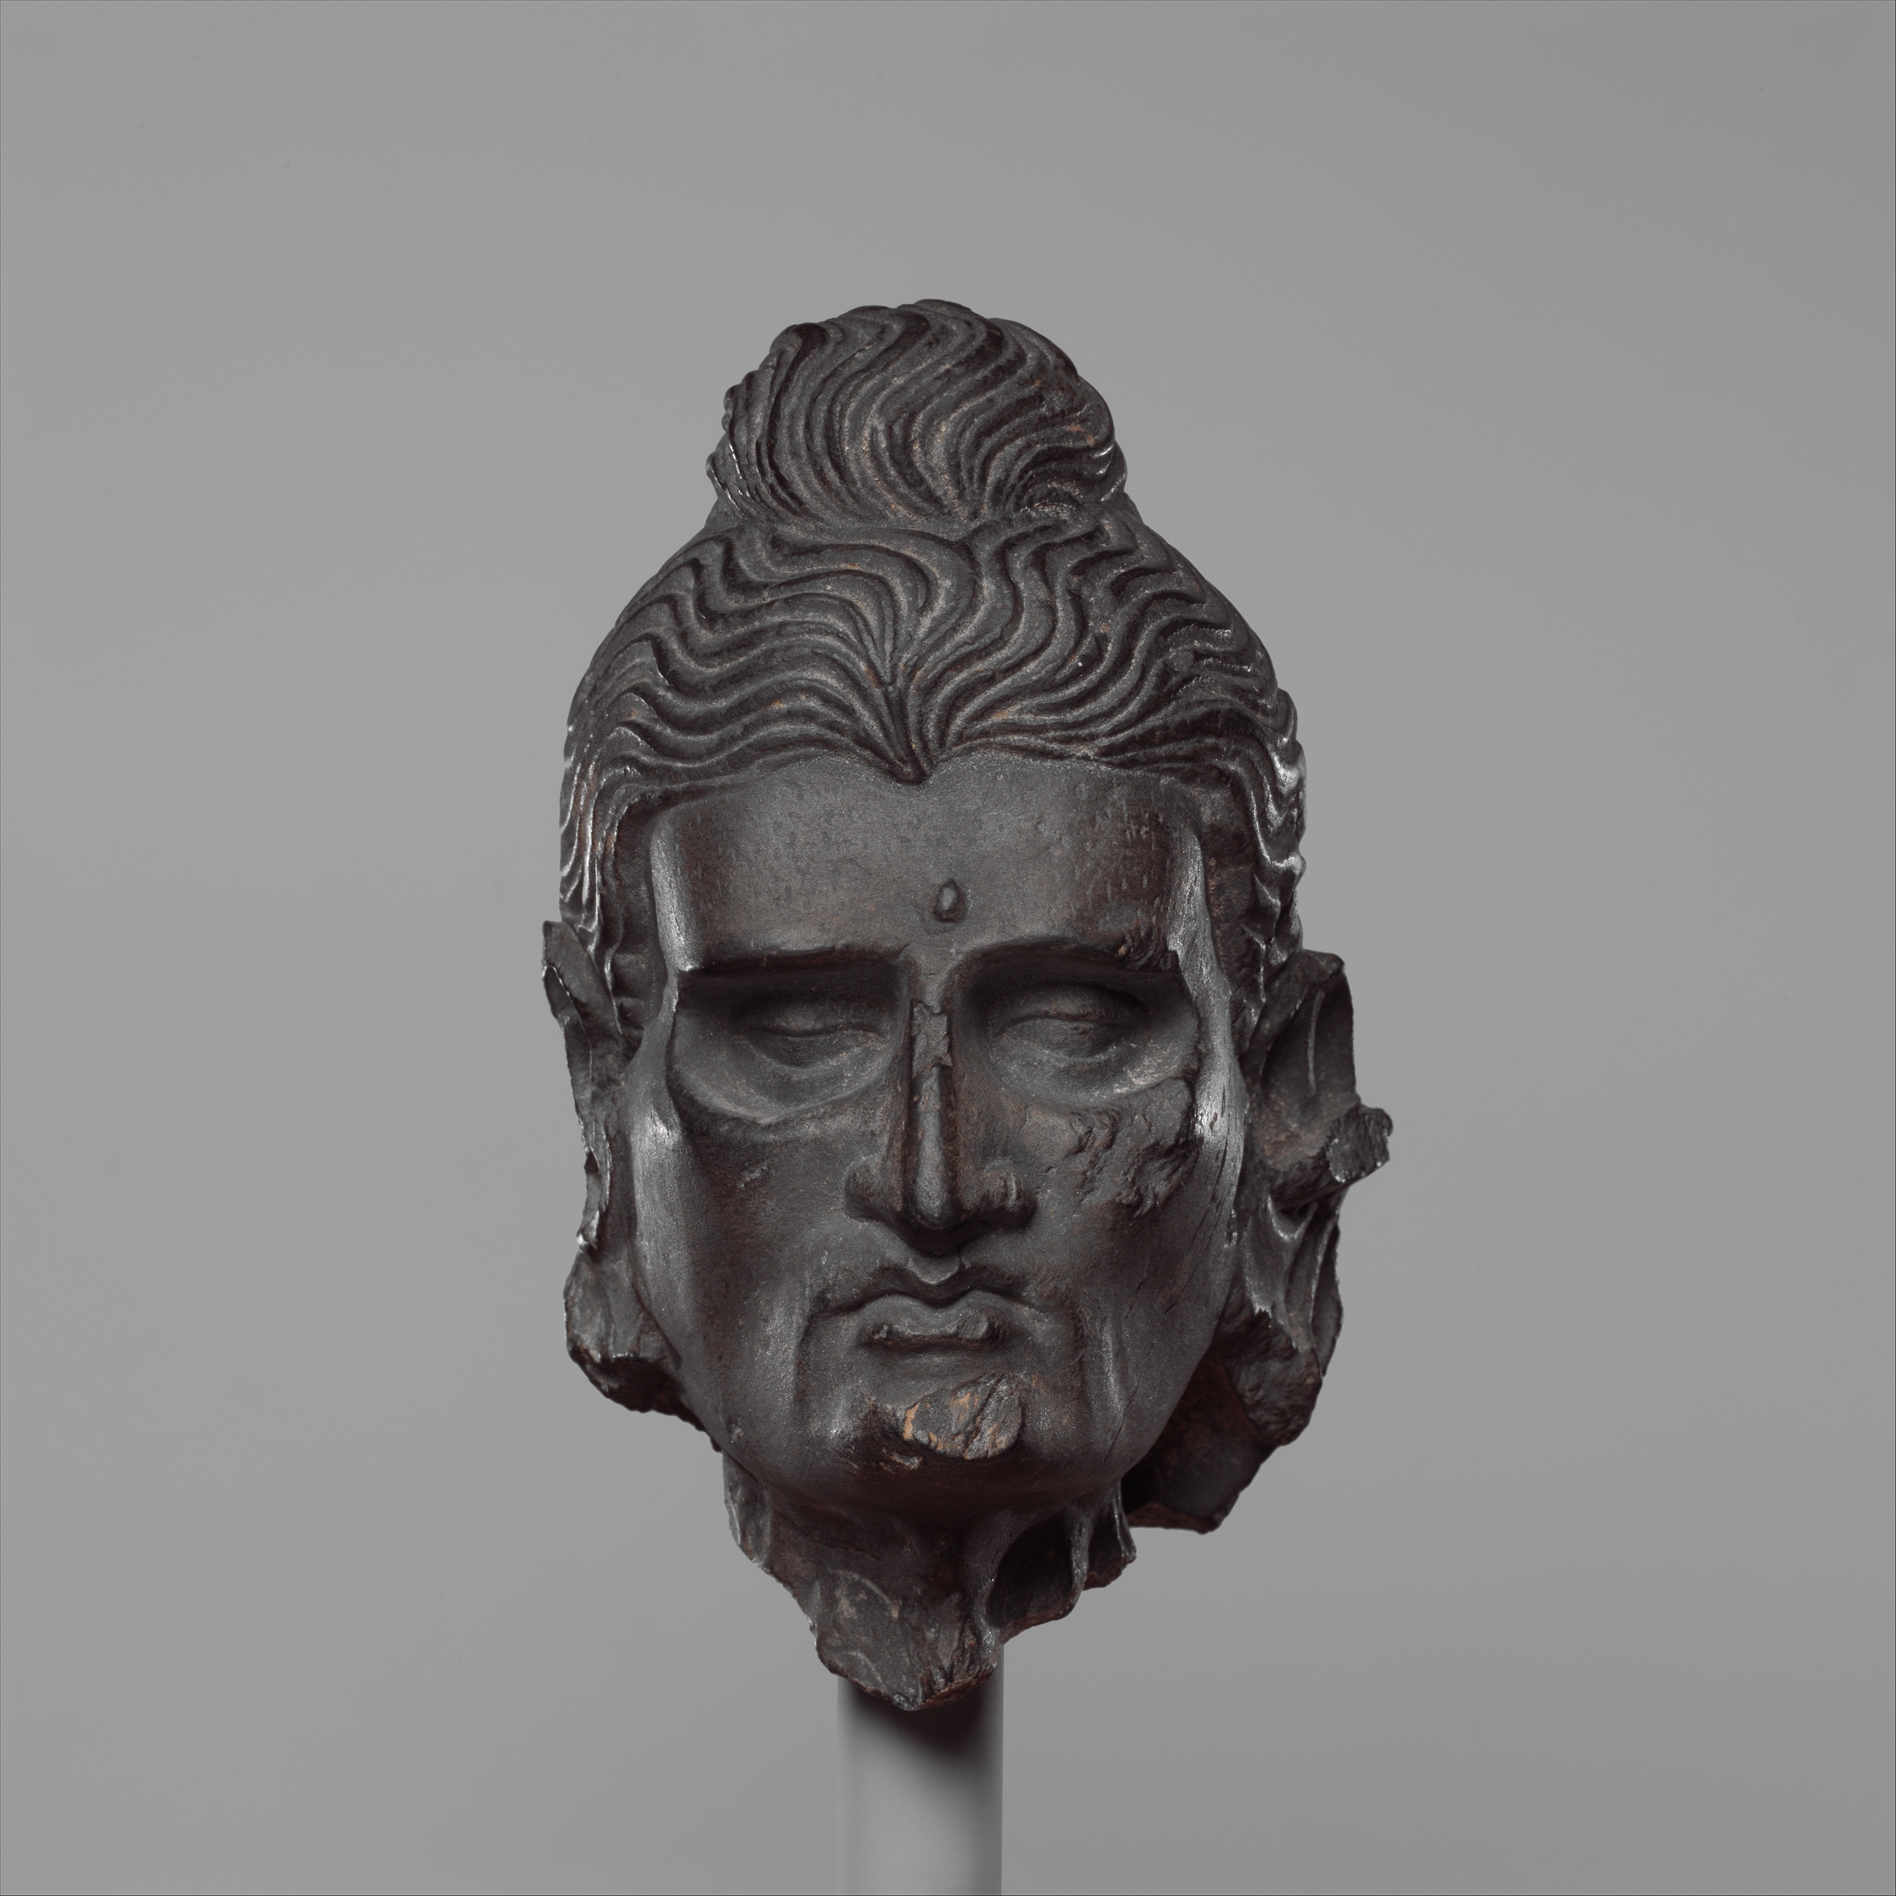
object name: head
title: Head of the Fasting Siddhartha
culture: gandhara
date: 201-500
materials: stone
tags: gandhara,heads,men,buddhism